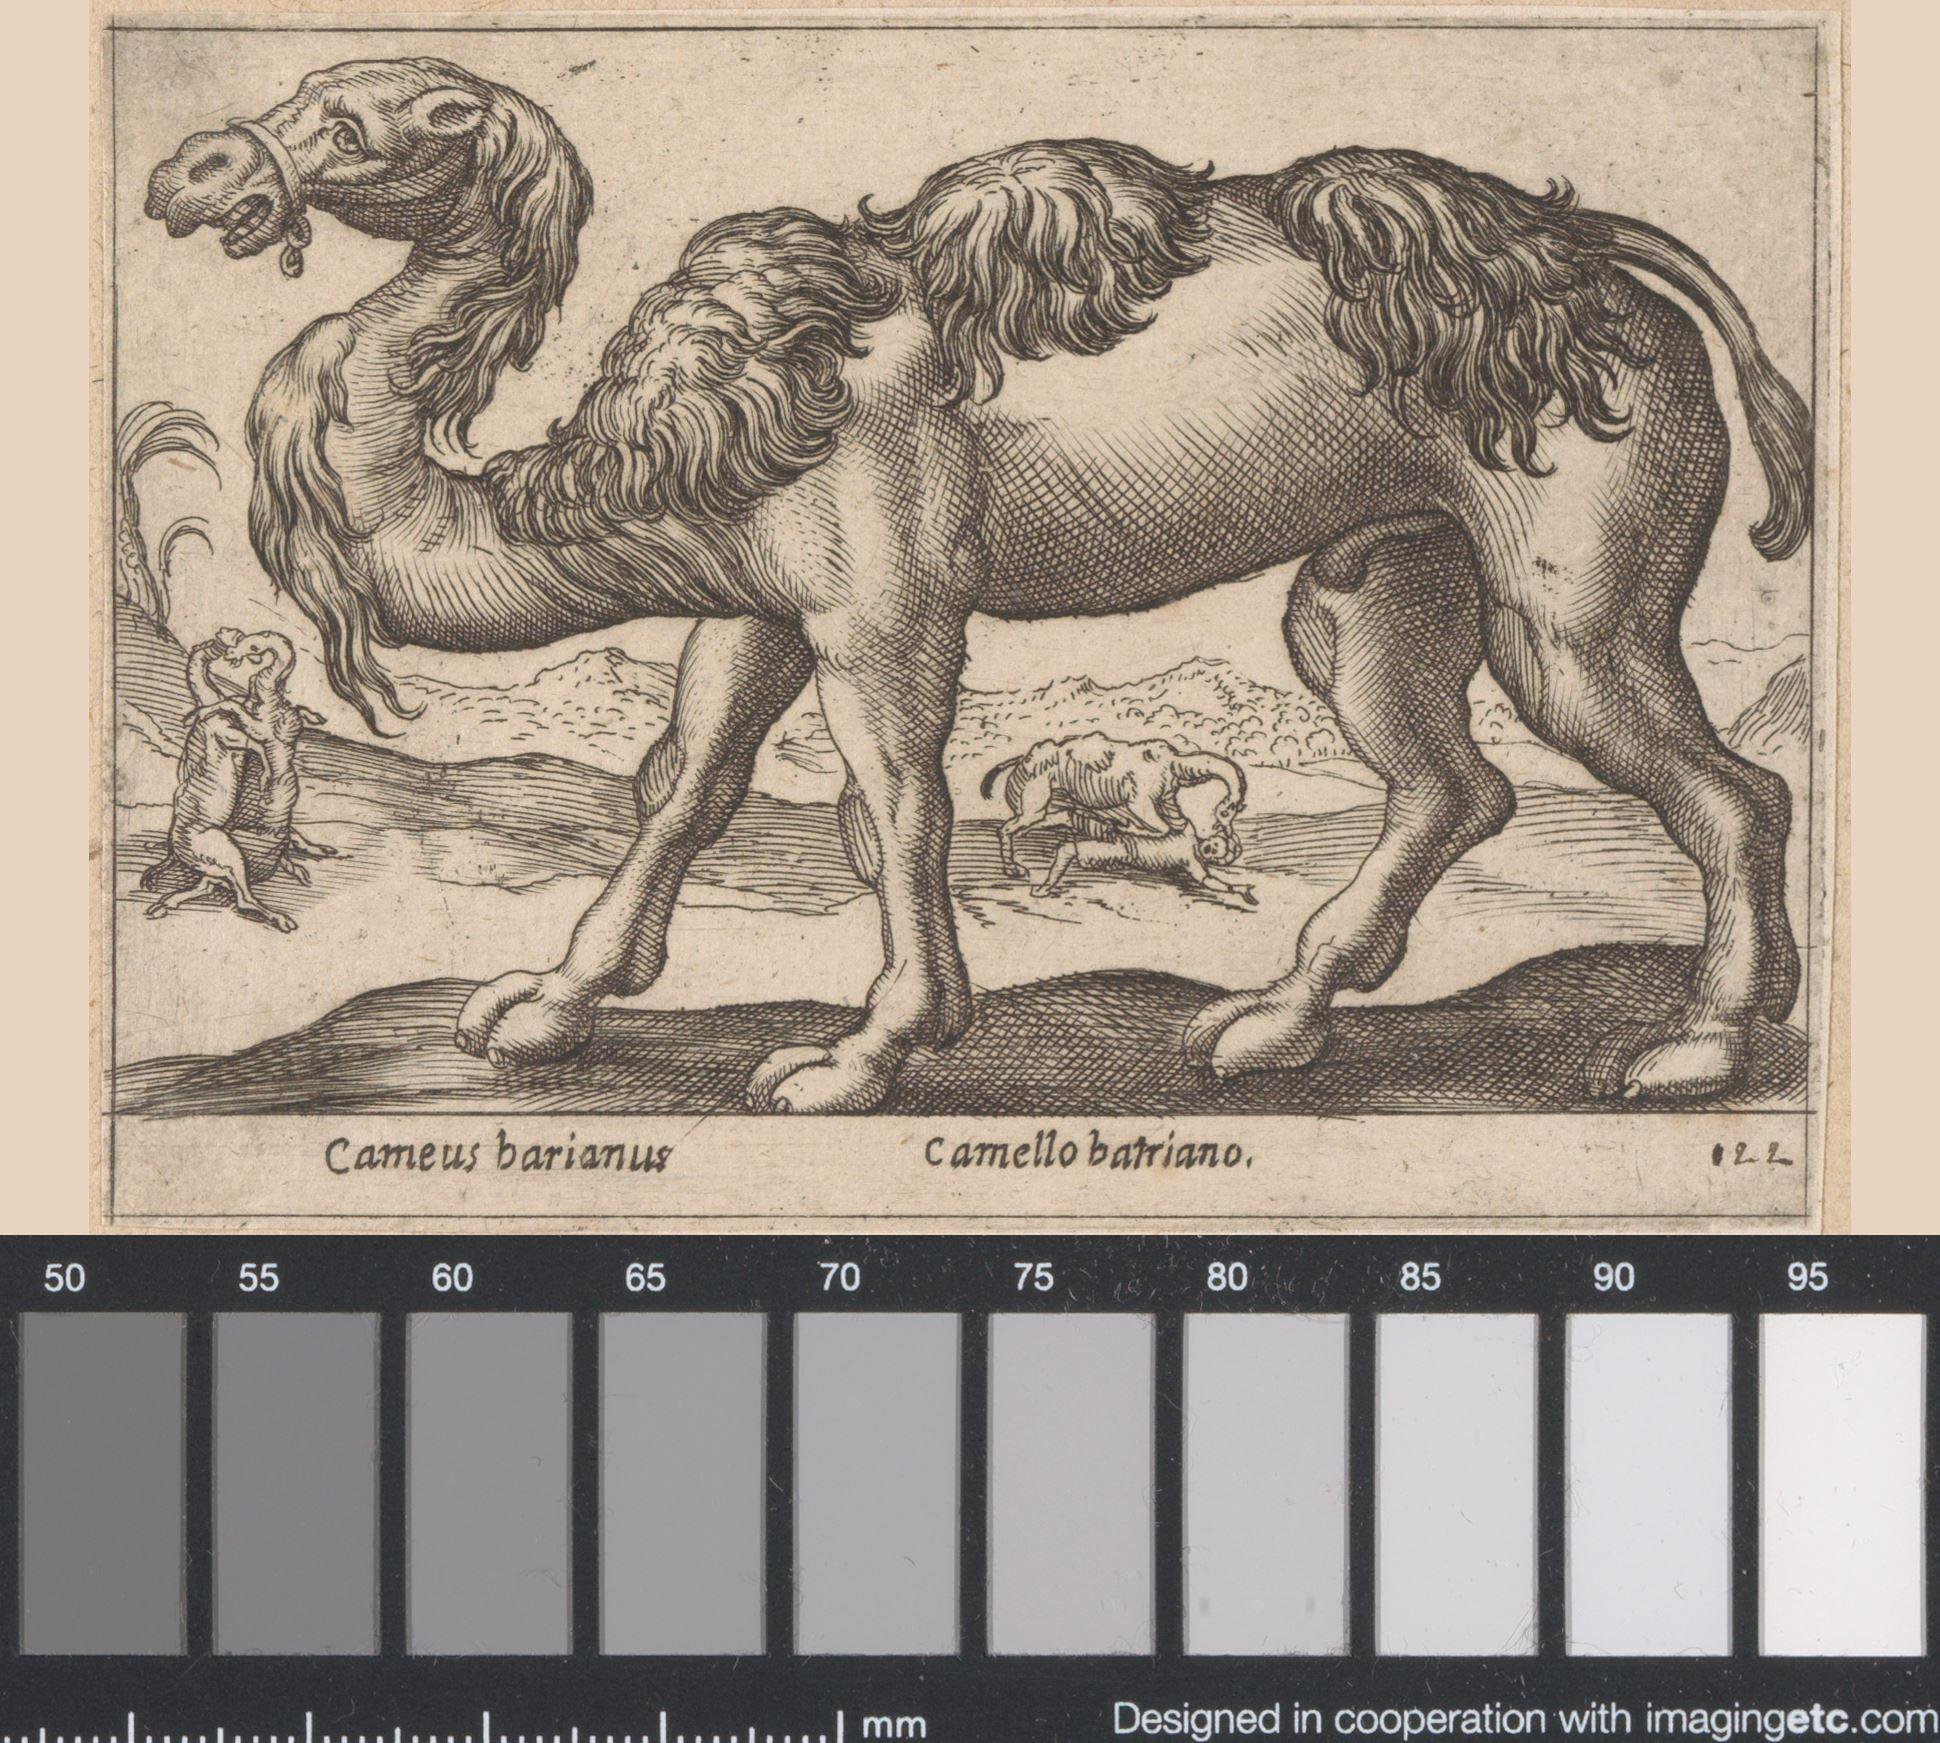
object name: print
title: Cameus barianus/ Camello batriano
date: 1565-1630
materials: paper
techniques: etching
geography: italy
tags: hoofed animals: camel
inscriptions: number: ‘122’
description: Deze prent maakt deel uit van een reeks prenten van dieren door Antonio Tempesta. Bekend is dat een tweede staat (met nummering) van deze serie is uitgegeven door Giovanni Giacomo de' Rossi in 1650. Onbekend is wie de eerste staat heeft uitgegeven en wanneer.